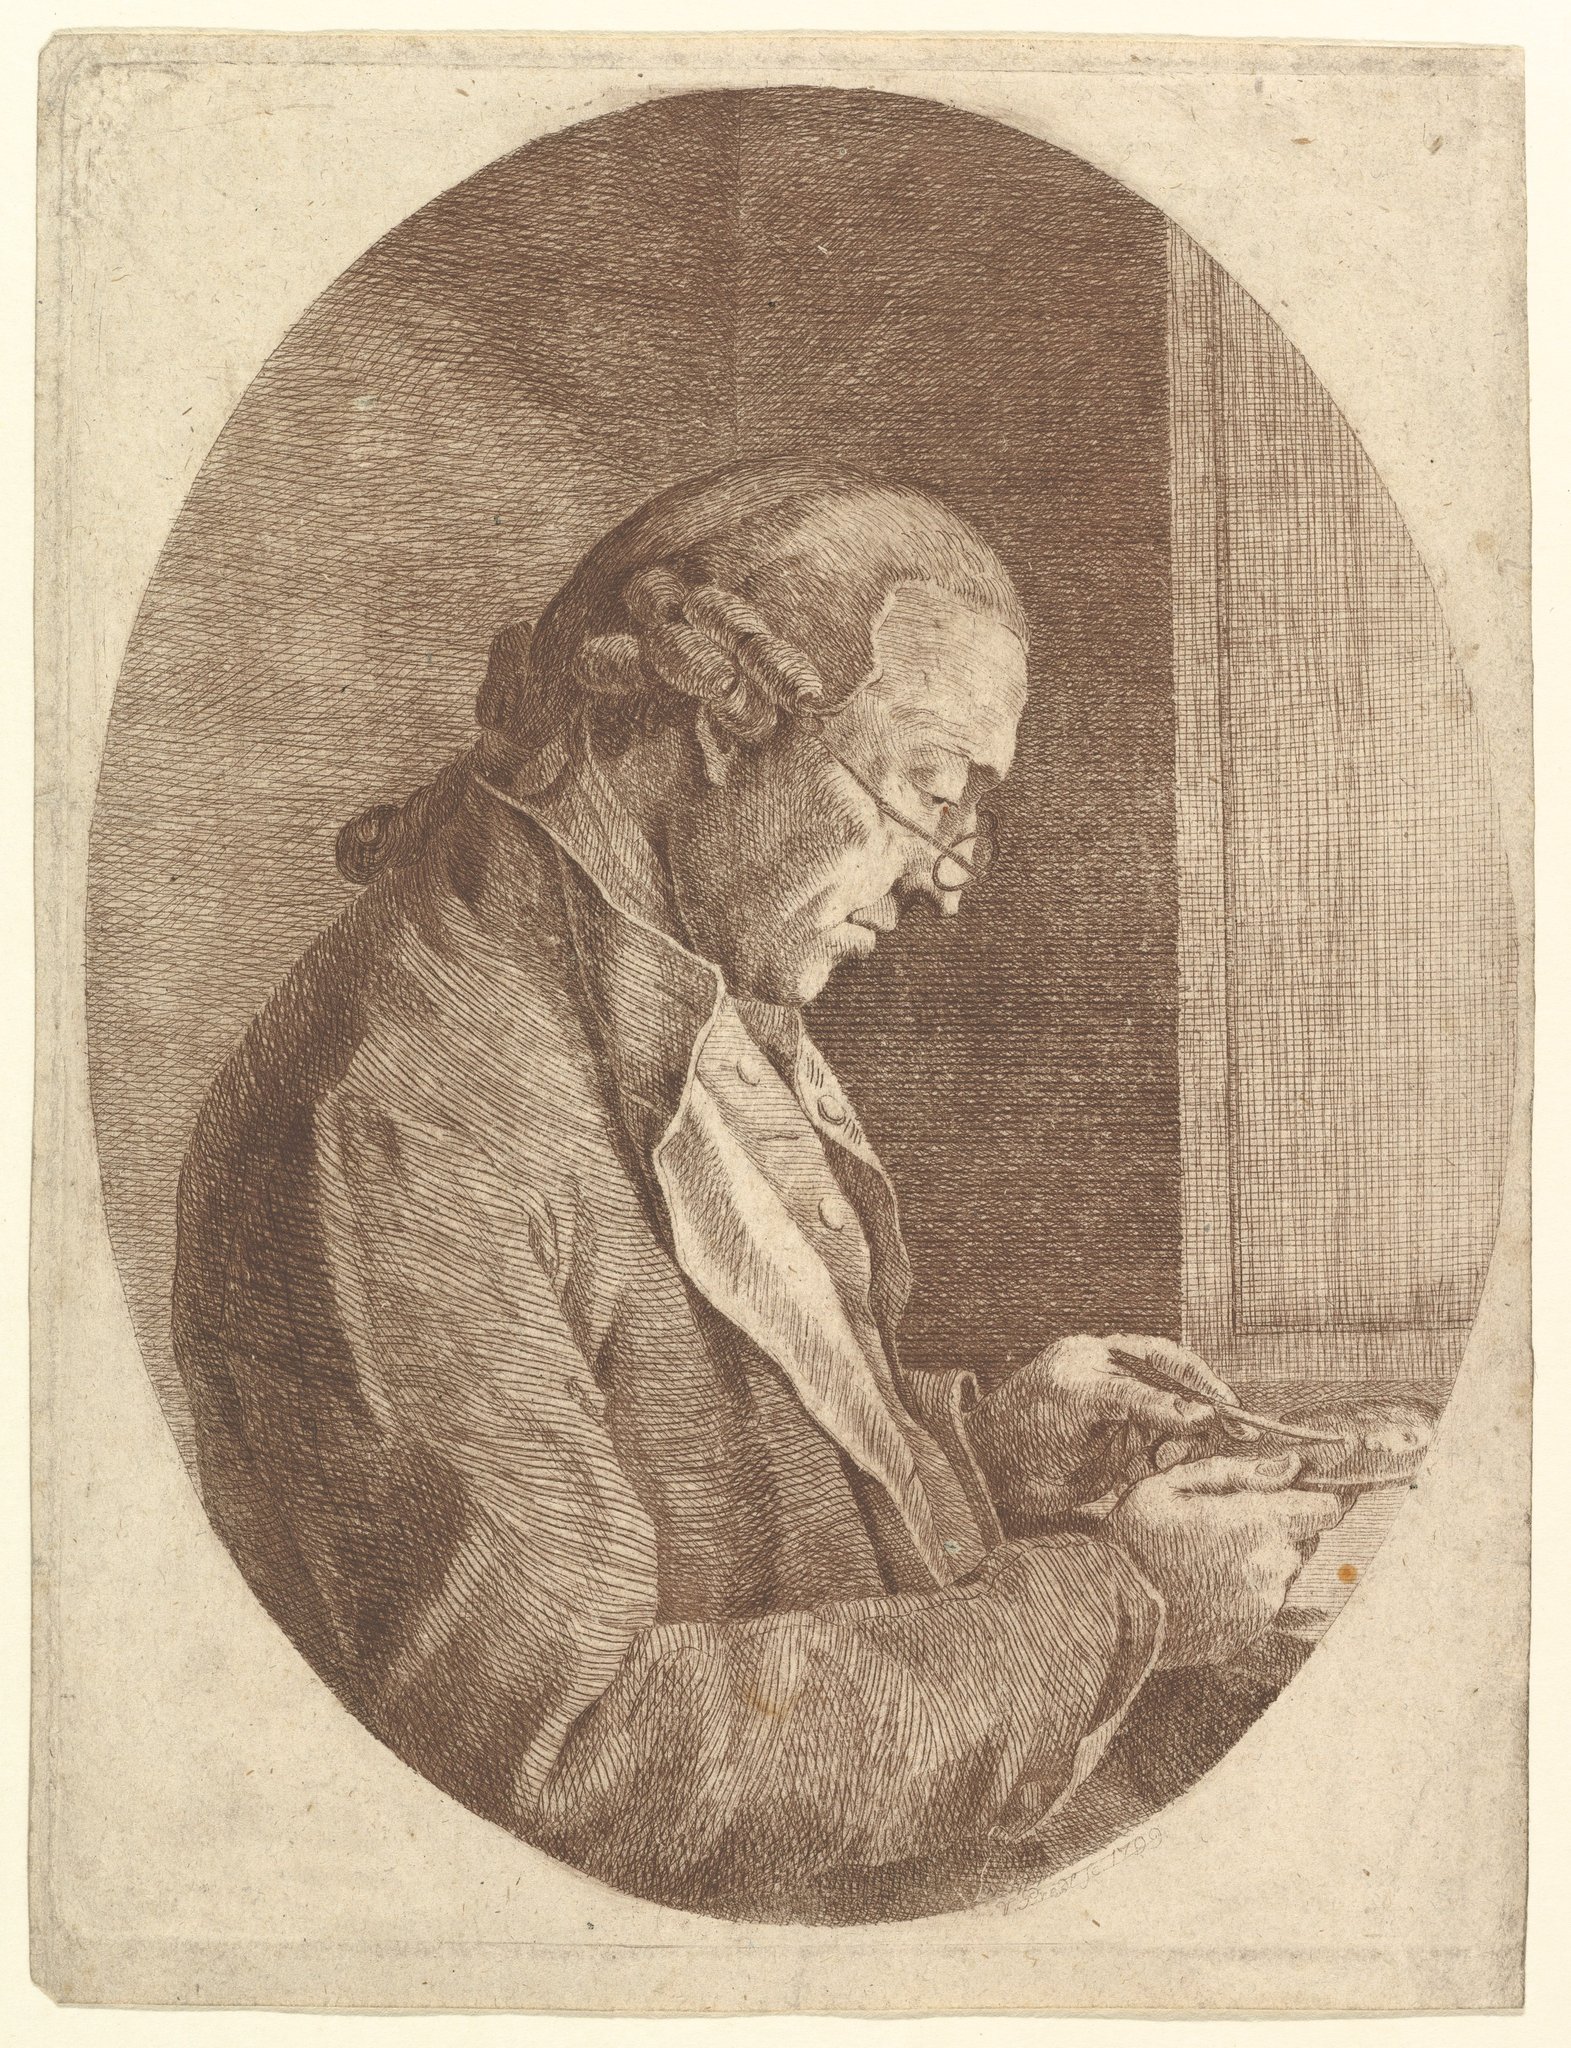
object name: print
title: Portrait of an Artist Sketching a Portrait Miniature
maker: franz jakob josef ignatz von predl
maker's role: artist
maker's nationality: german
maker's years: 1759-1806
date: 1799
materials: ink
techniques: engraving, printing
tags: men,artists